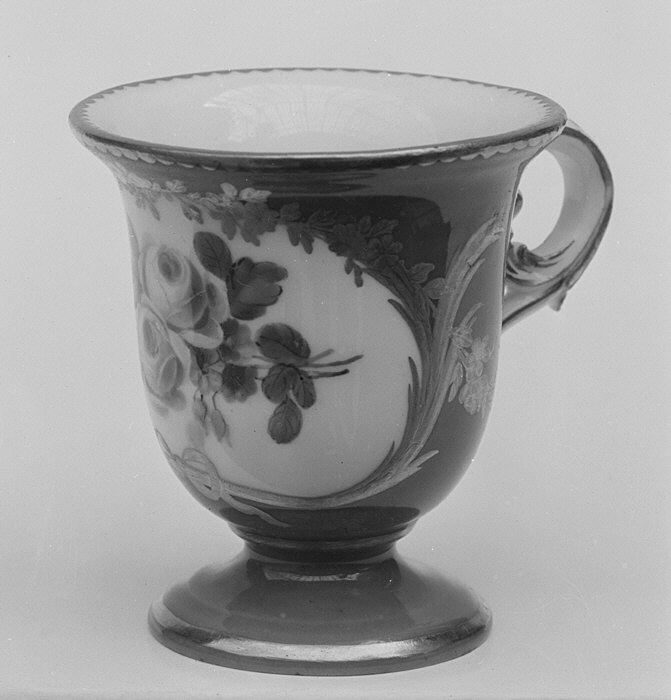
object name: ice cream cup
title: Ice cream cup (tasse à glace) (one of thirty-one) (part of a service)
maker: sèvres manufactory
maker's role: manufactory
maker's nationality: french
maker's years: 1740-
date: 1771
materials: soft paste porcelain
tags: flowers